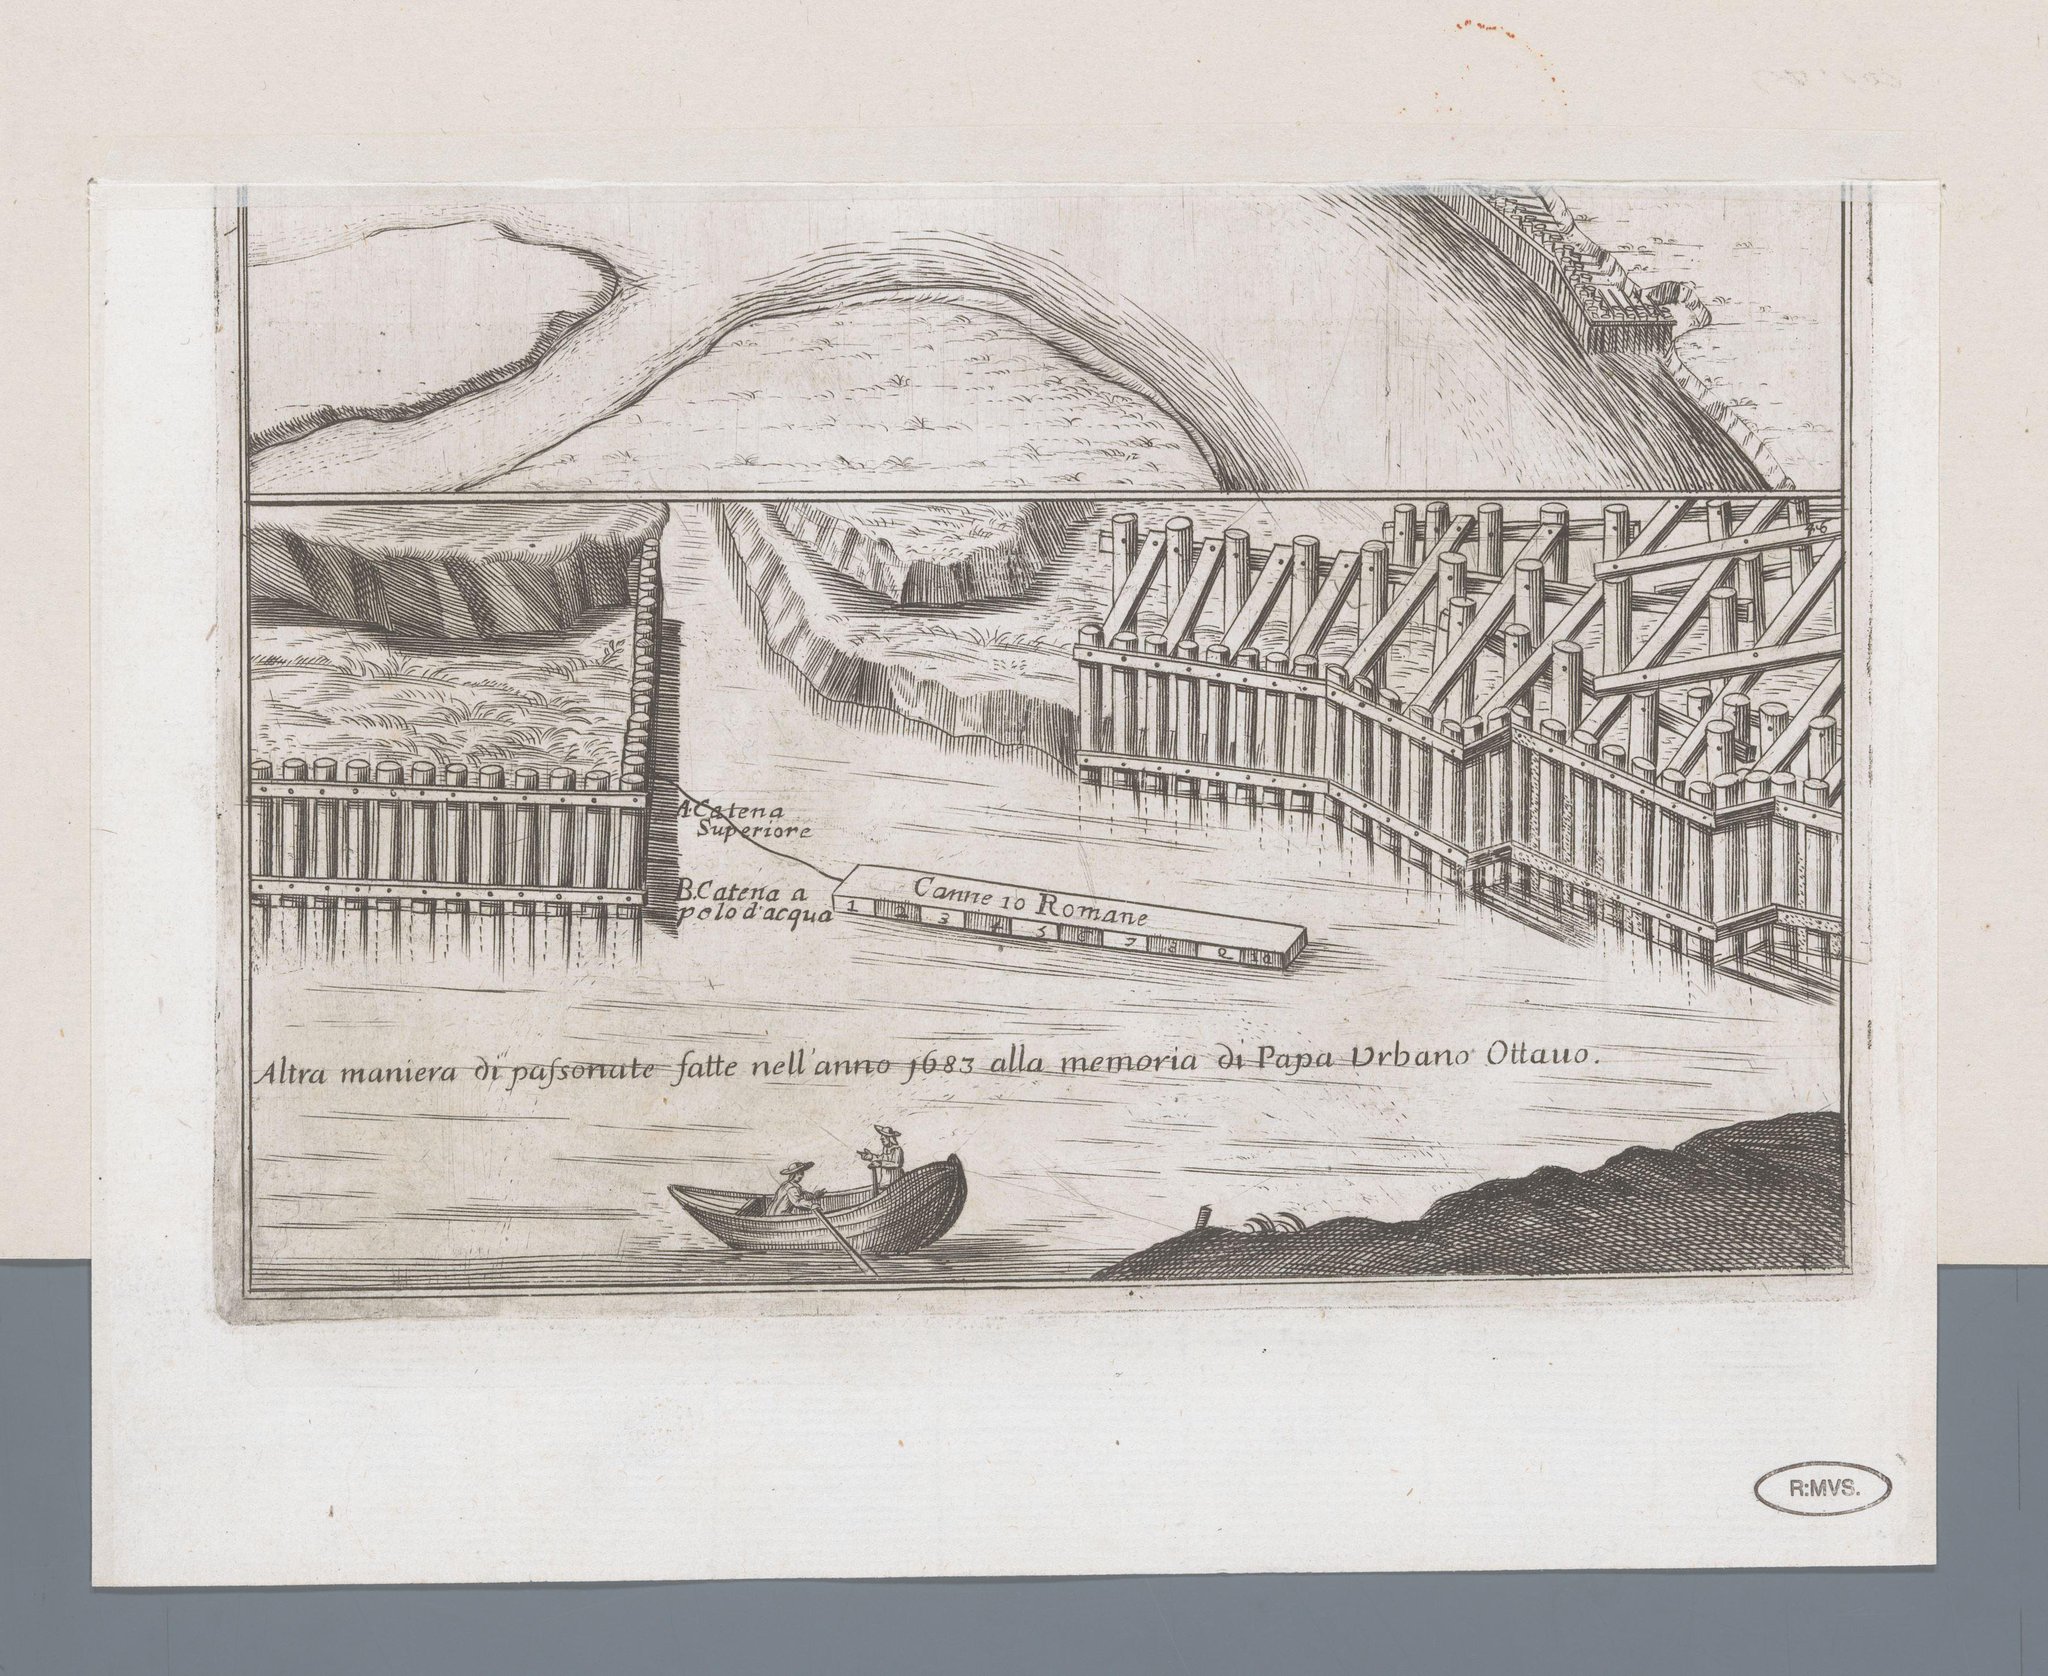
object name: print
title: Twee voorstellingen van dammen in dezelfde rivier in 1682 en 1683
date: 1696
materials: paper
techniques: etching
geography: rome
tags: river, dam (in canal)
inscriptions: collector's mark: Lugt 2228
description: Prent uit: L'arte di rendere i fiumi navigabili, in varij modi, con altre nuove inventioni, e varij altri segreti. Rome: Giovanni Giacomo Komarek, 1696.